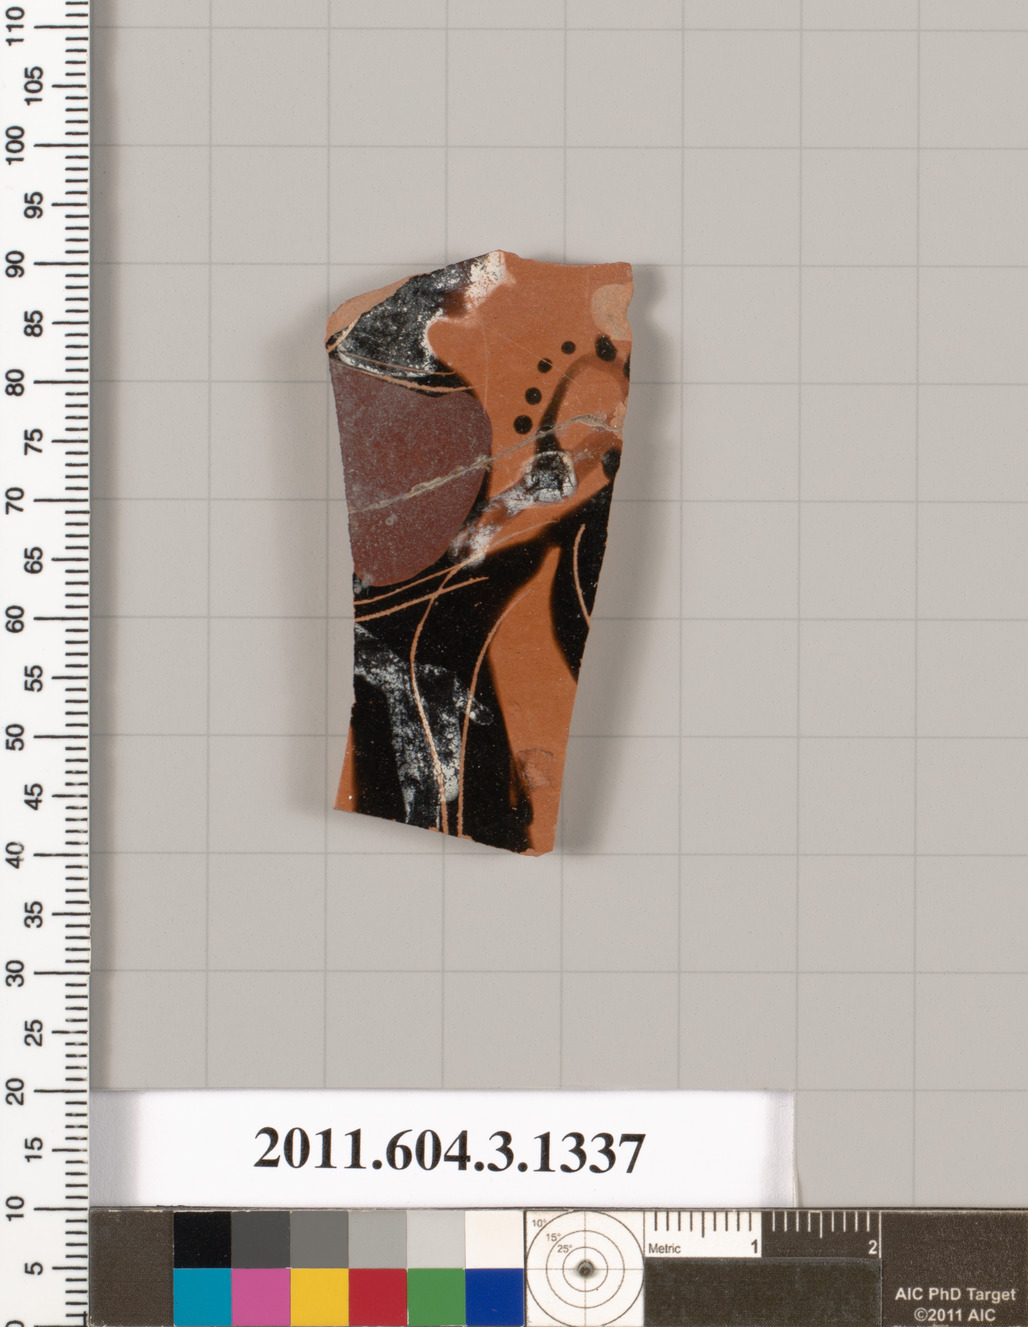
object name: skyphos fragment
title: Terracotta fragment of a skyphos (deep drinking cup)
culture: greek, attic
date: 500-468 BCE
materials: terracotta